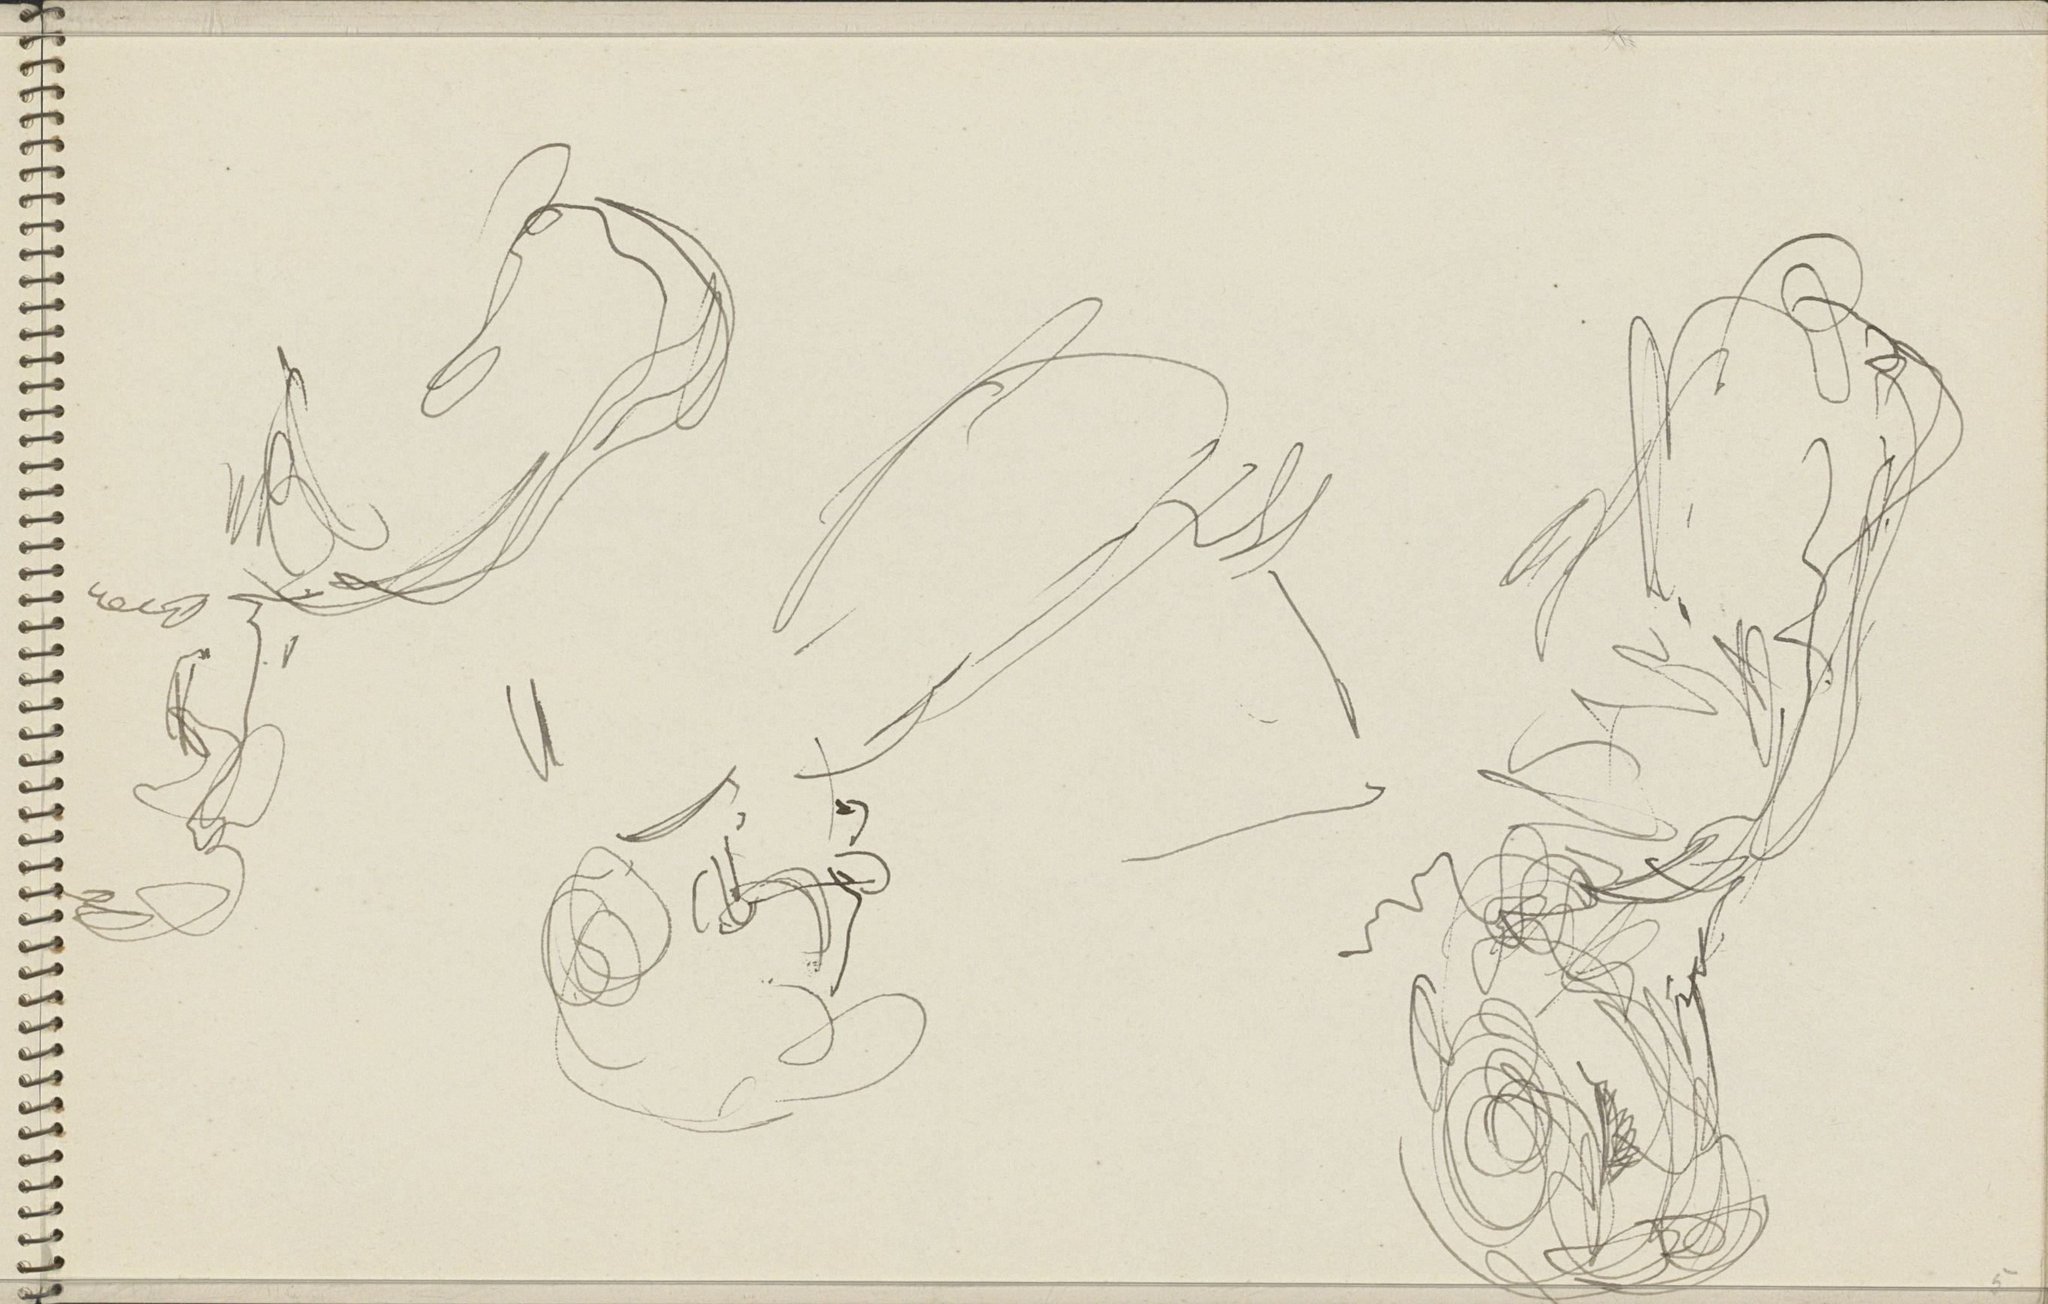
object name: sketchbook leaf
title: Lezende Joanna Lion Cachet-Cordes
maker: carel adolph lion cachet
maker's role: draughtsman, print maker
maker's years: 1864-1945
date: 1935-1940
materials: ink, paper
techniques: pen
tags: adult woman, reading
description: Tevens twee studies van Joanna Lion Cachet-Cordes zonder krant. Blad 5 recto uit een schetsboek met 25 bladen.